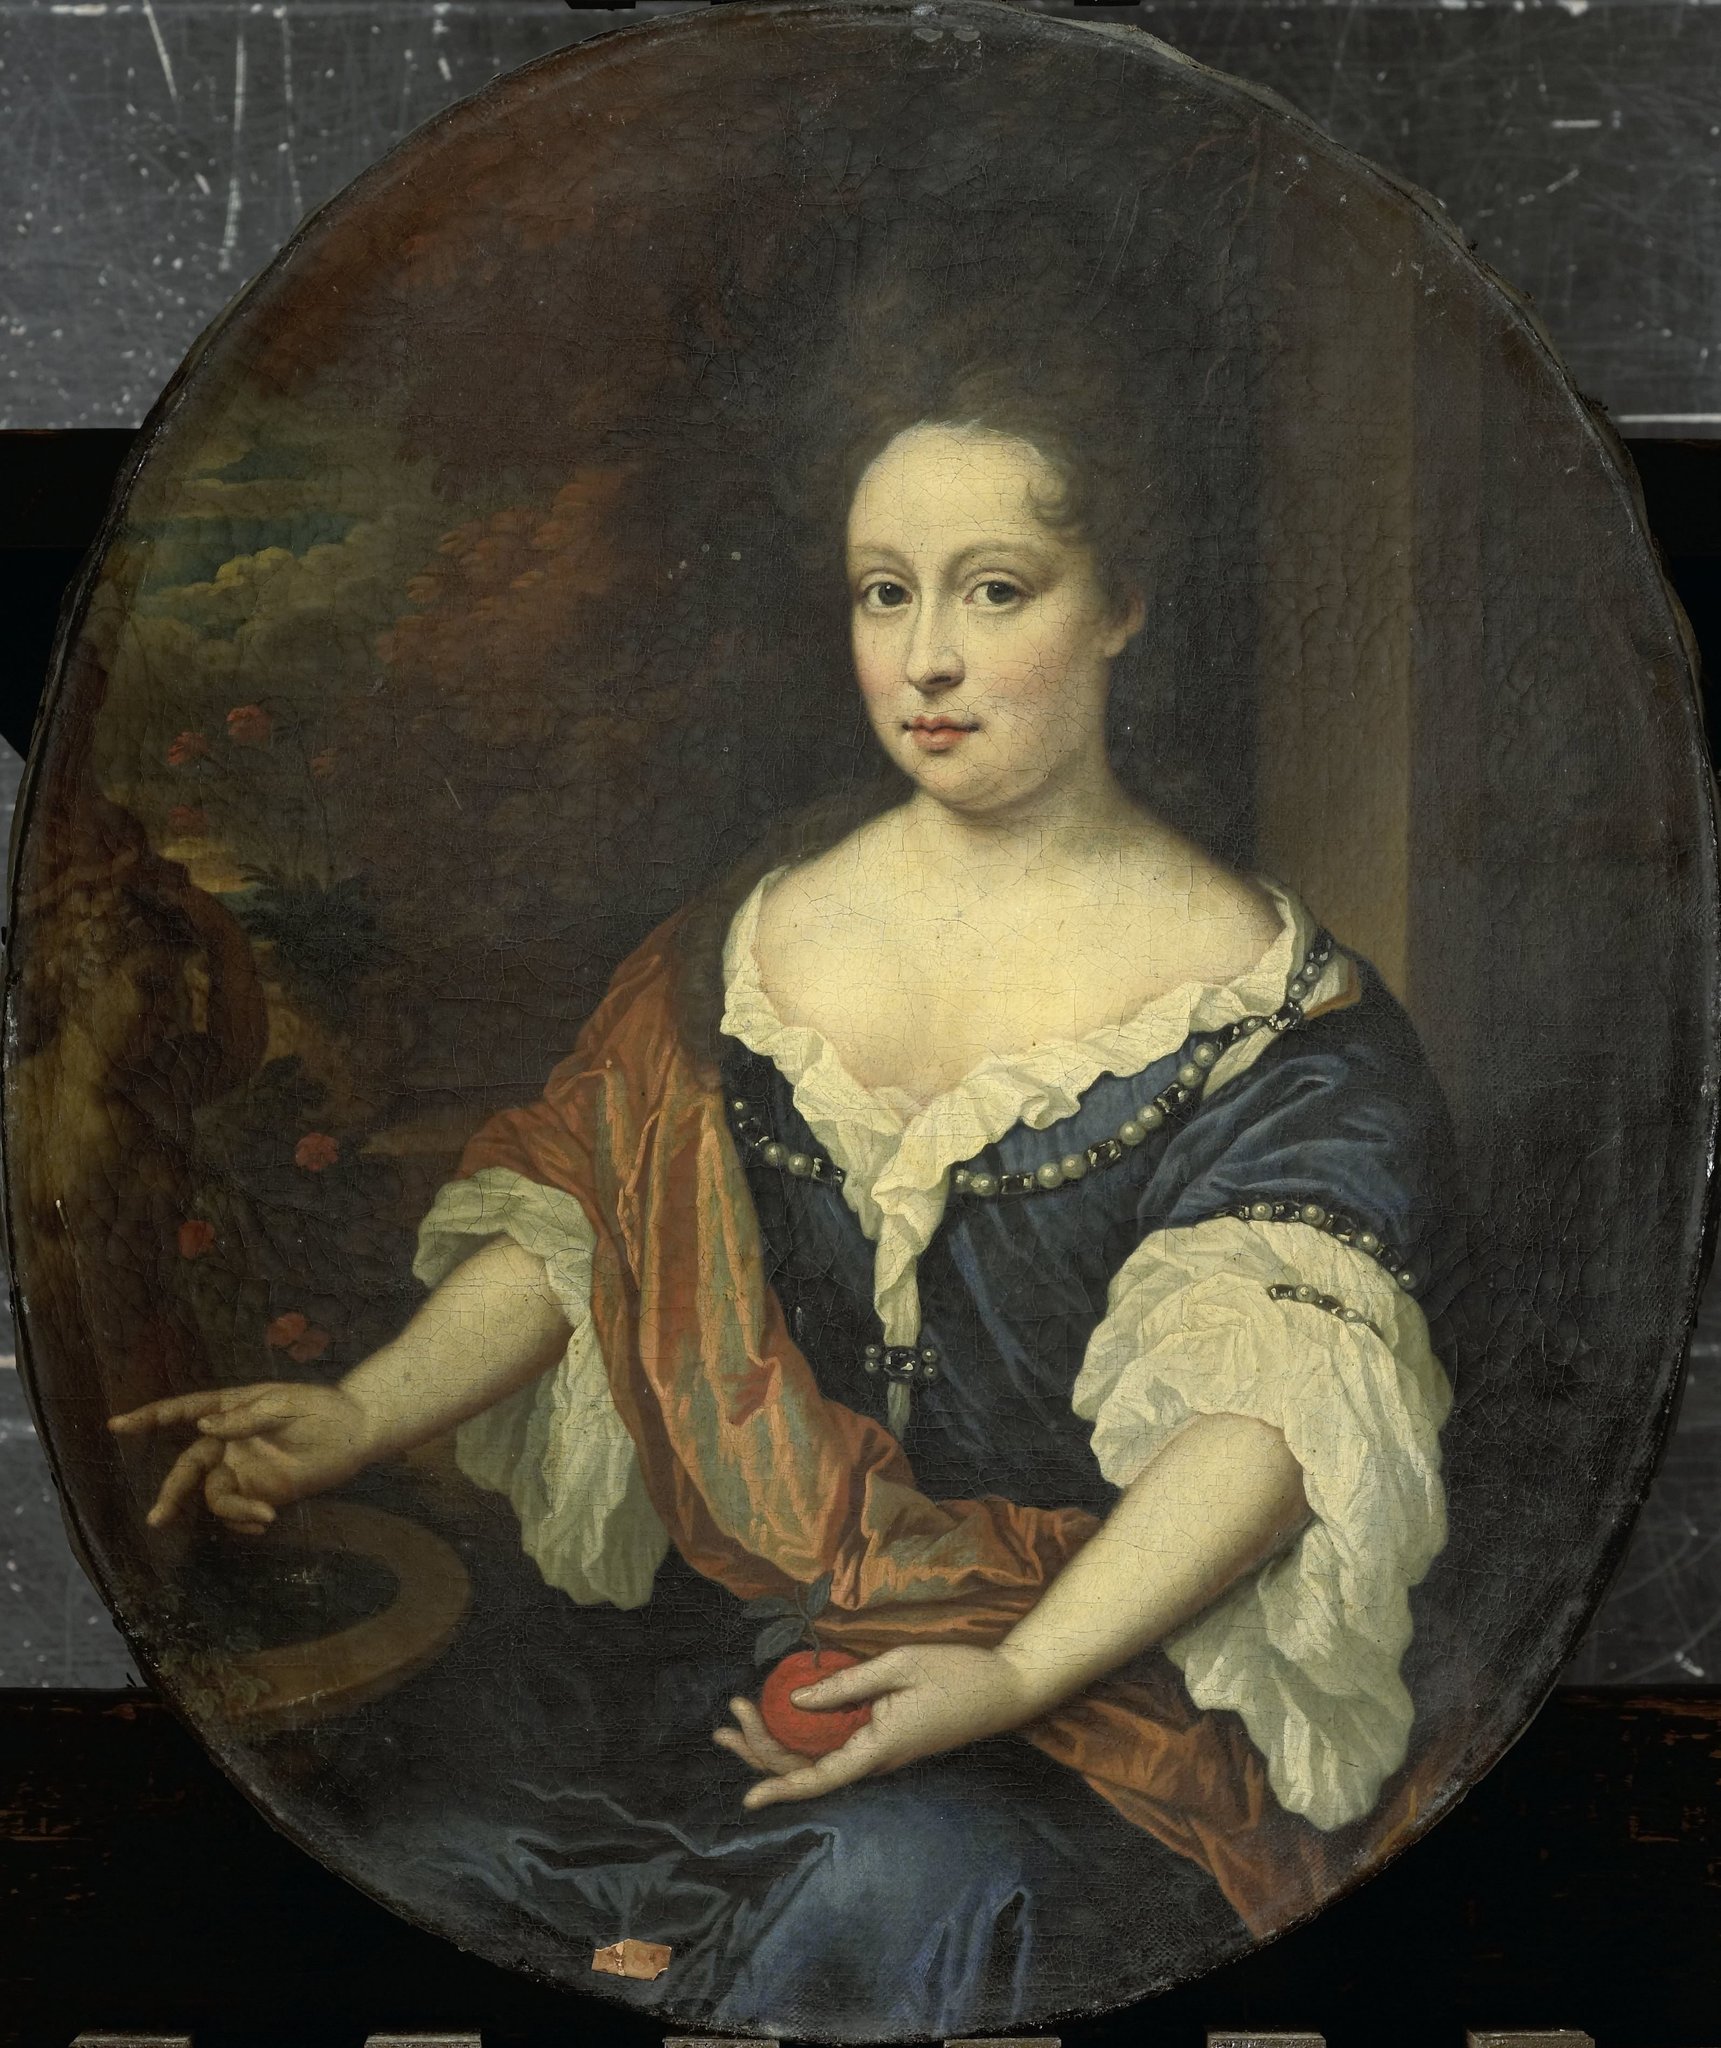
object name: painting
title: Judith Allijn (d 1702), Wife of Harmen Lijnslager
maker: jan van haensbergen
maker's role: painter, print maker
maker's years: 1642-1705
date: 1699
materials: canvas, oil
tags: plymouth, amsterdam, historical persons - bb - woman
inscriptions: signature and date: ‘J.V.H. f. 1699’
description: Portret van Judith Allijn, echtgenote van Harmen Lijnslager. Kniestuk in ovaal, zittend bij een fontein met een sinaasappel in de linkerhand. Pendant van SK-C-1546.